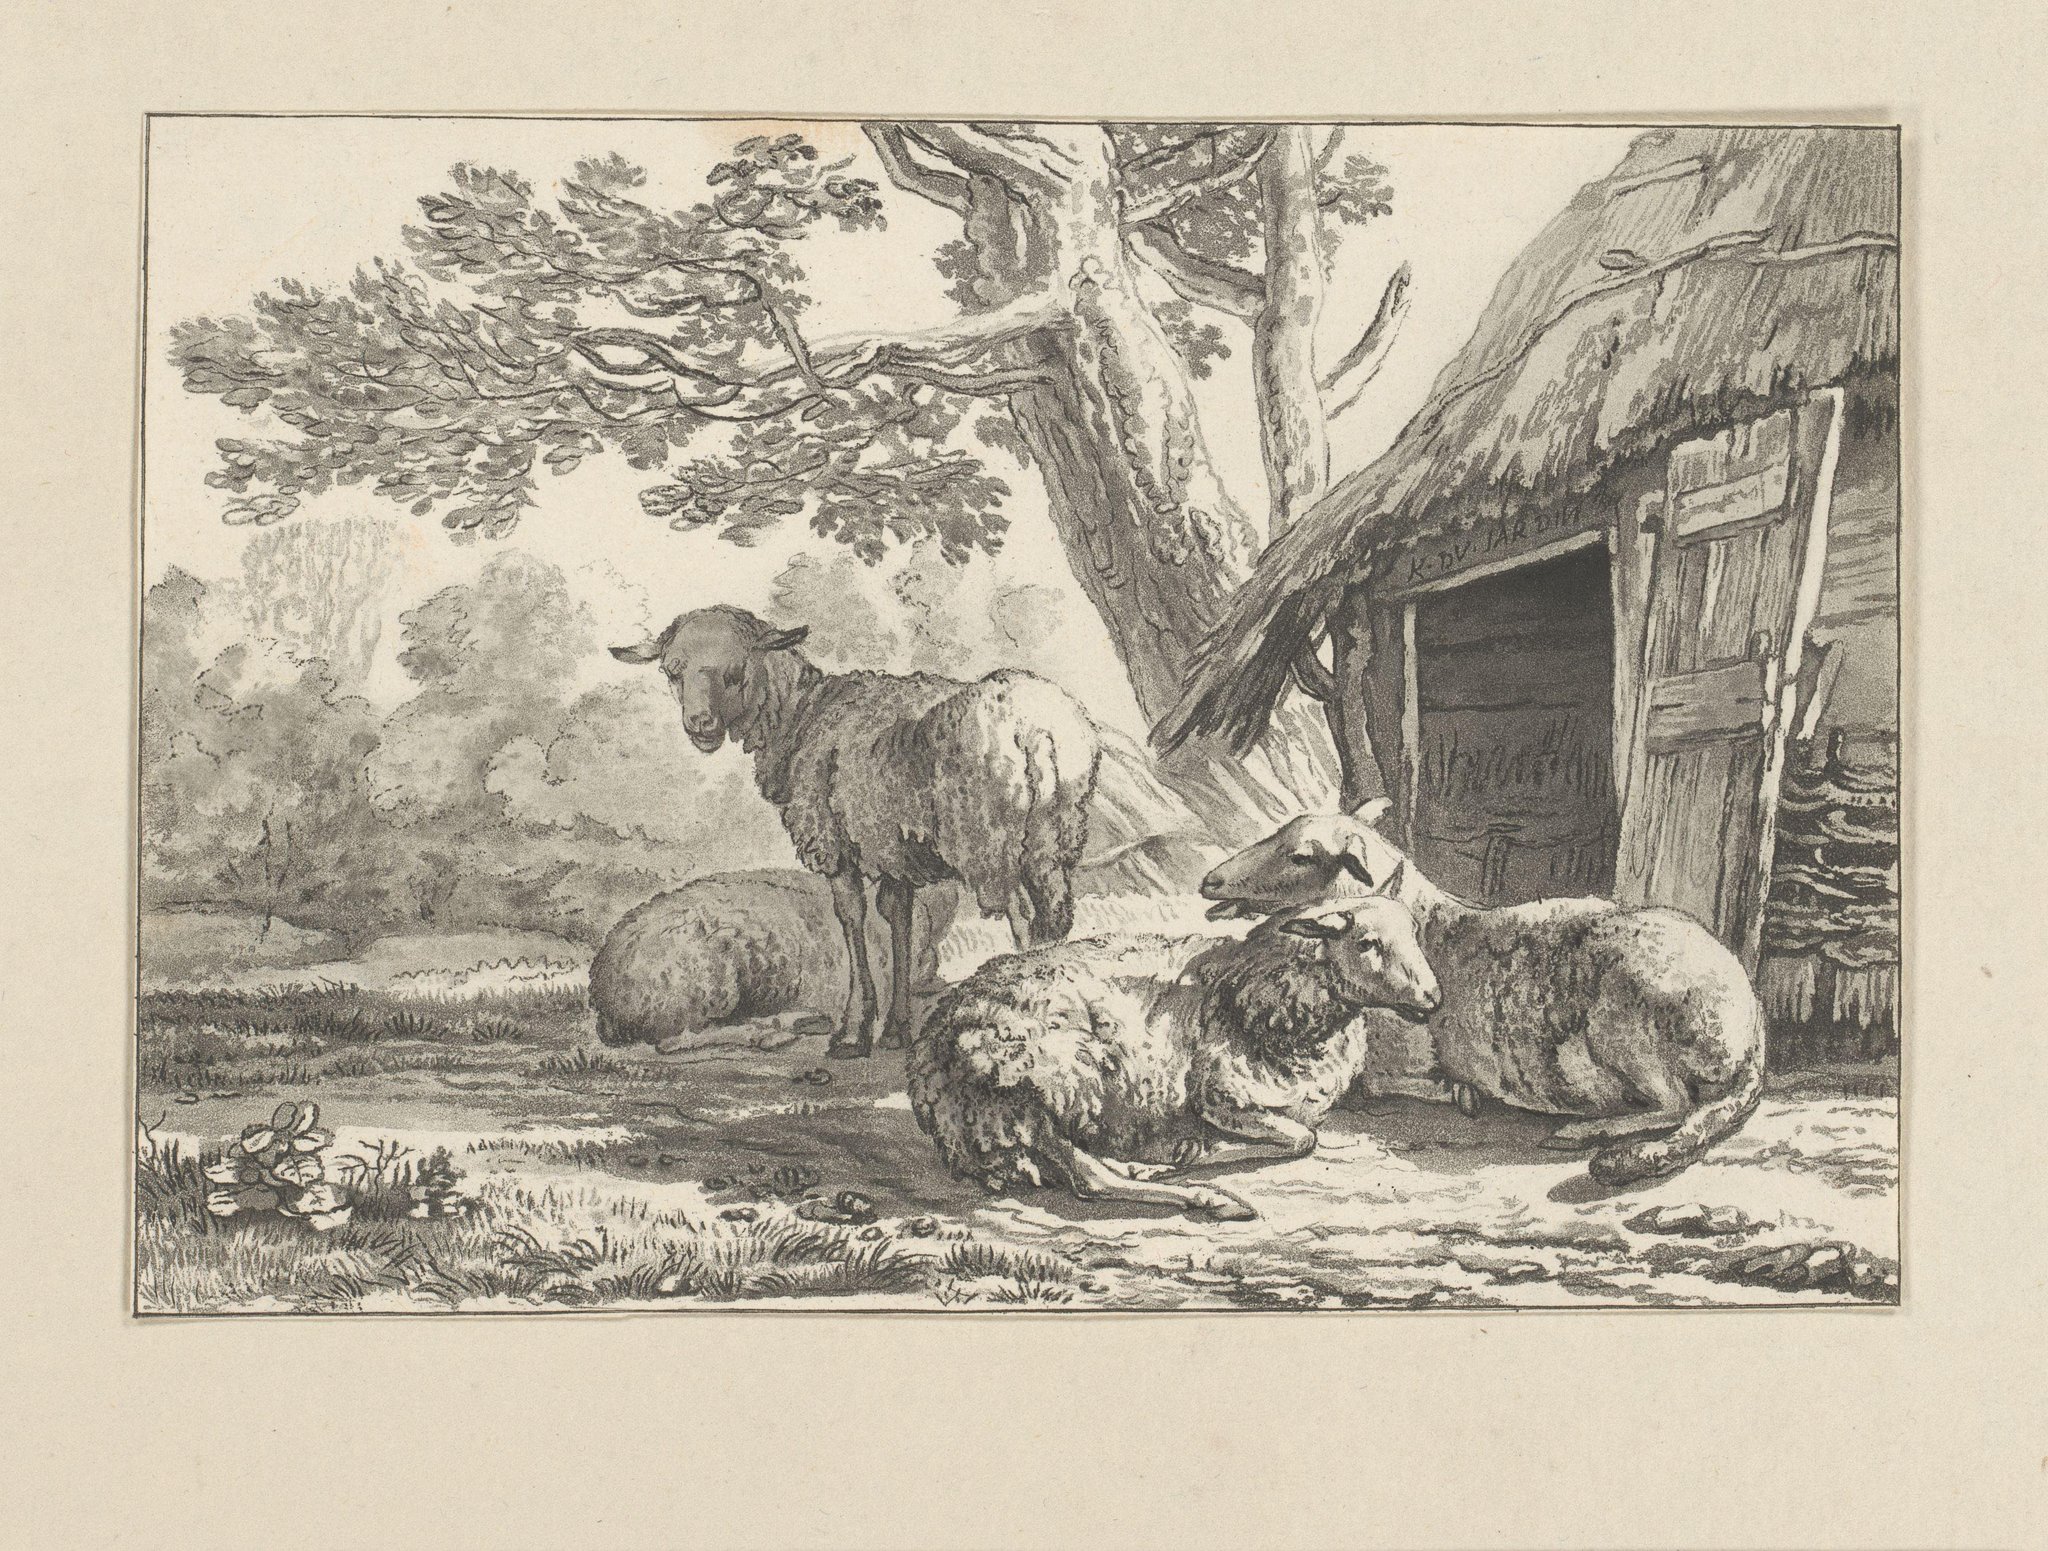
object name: print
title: Schaapskooi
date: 1781-1787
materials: paper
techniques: etching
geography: amsterdam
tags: sheep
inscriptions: collector's mark: Lugt 2725, collector's mark: ‘RIJKS / MUSM’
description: Vier schapen bij de geopende schaapskooi. De prent maakt deel uit van een album, zie blad 44.